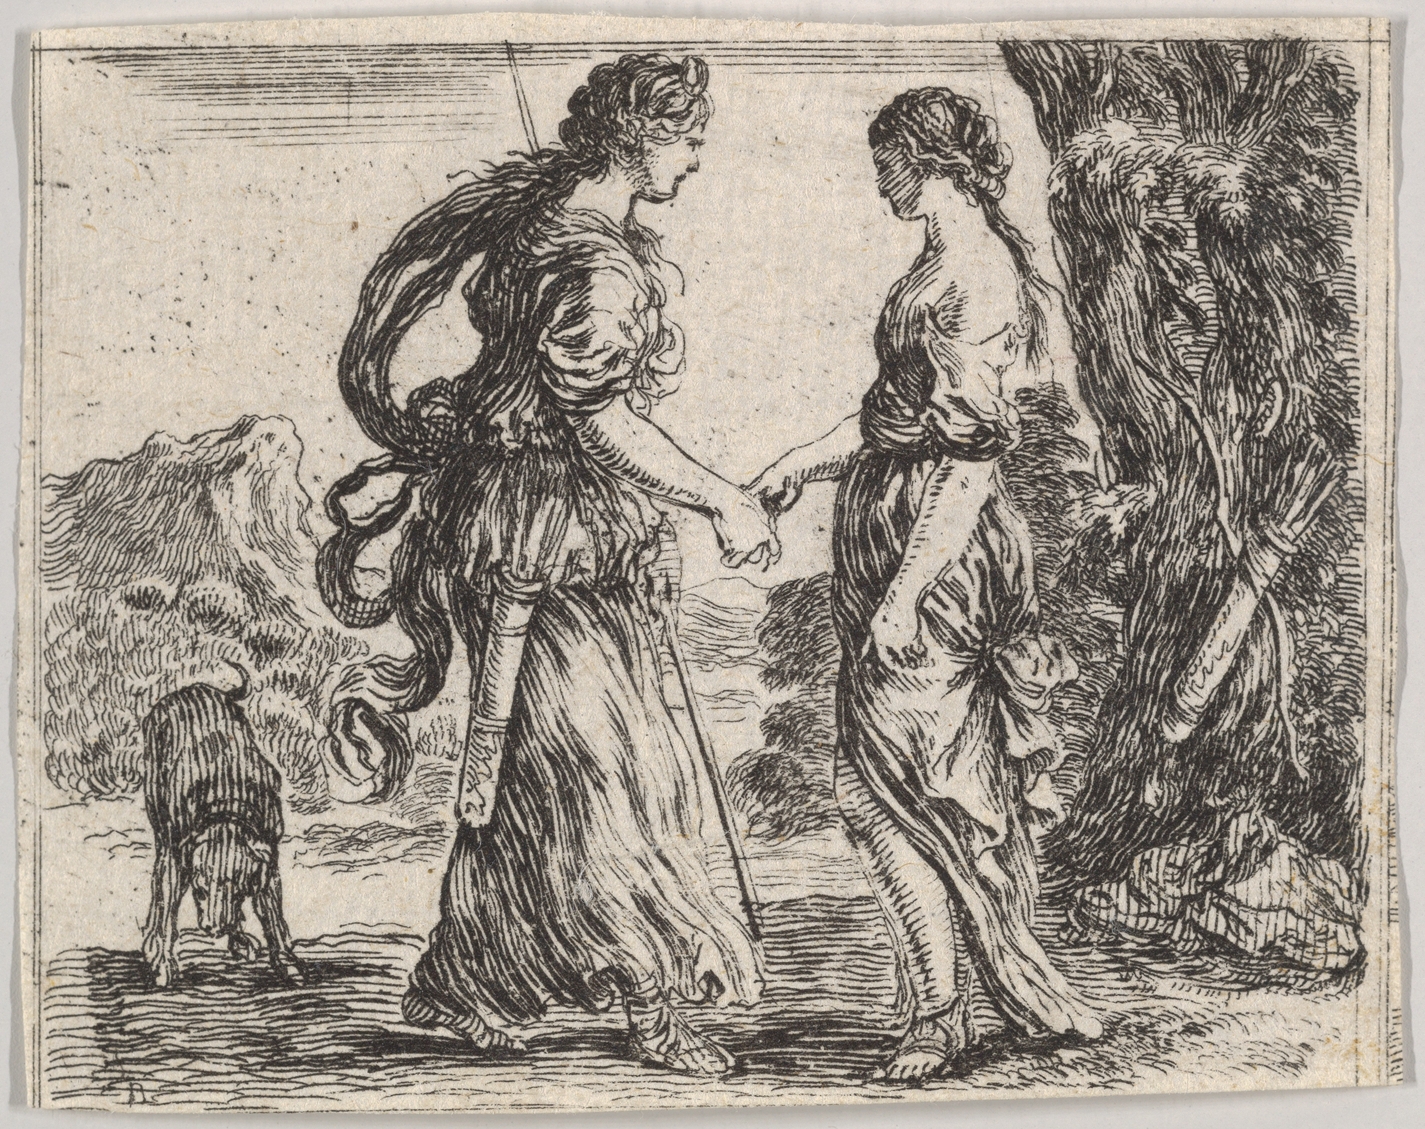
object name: print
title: Jupiter and Calisto, from "Game of Mythology" (Jeu de la Mythologie)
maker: stefano della bella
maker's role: artist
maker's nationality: italian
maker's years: 1610-1664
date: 1644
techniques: etching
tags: nymphs,jupiter,dogs,hills